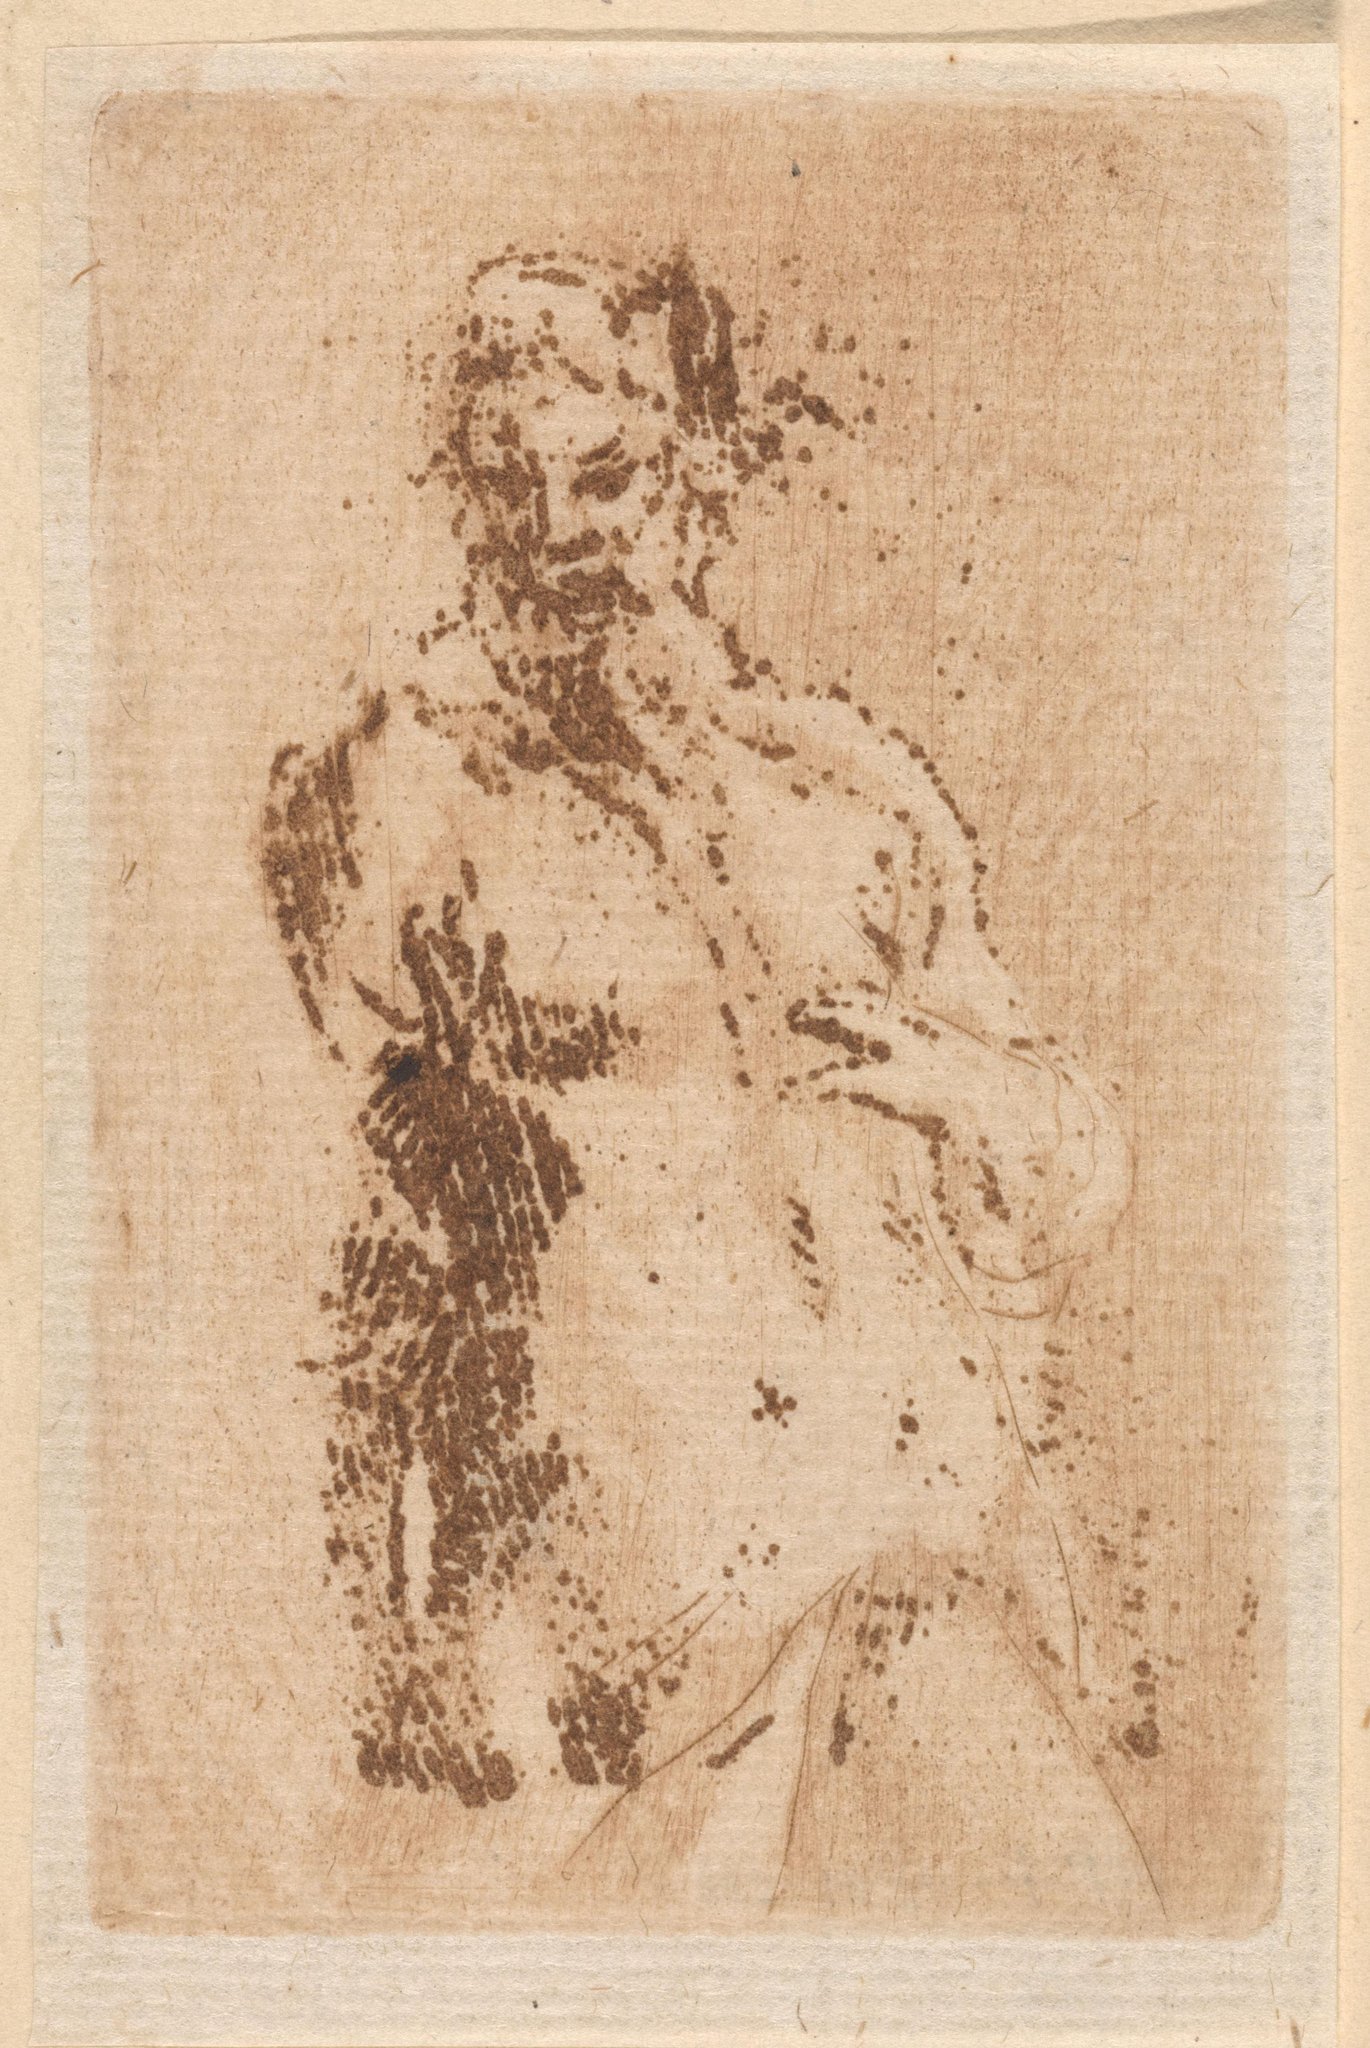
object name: print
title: Landschapjes, Rúwientjes enz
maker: caspar jacobsz. philips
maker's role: draughtsman, print maker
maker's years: 1732-1789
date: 1766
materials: paper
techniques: etching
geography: amsterdam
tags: the (nude) human figure; 'corpo humano' (ripa)